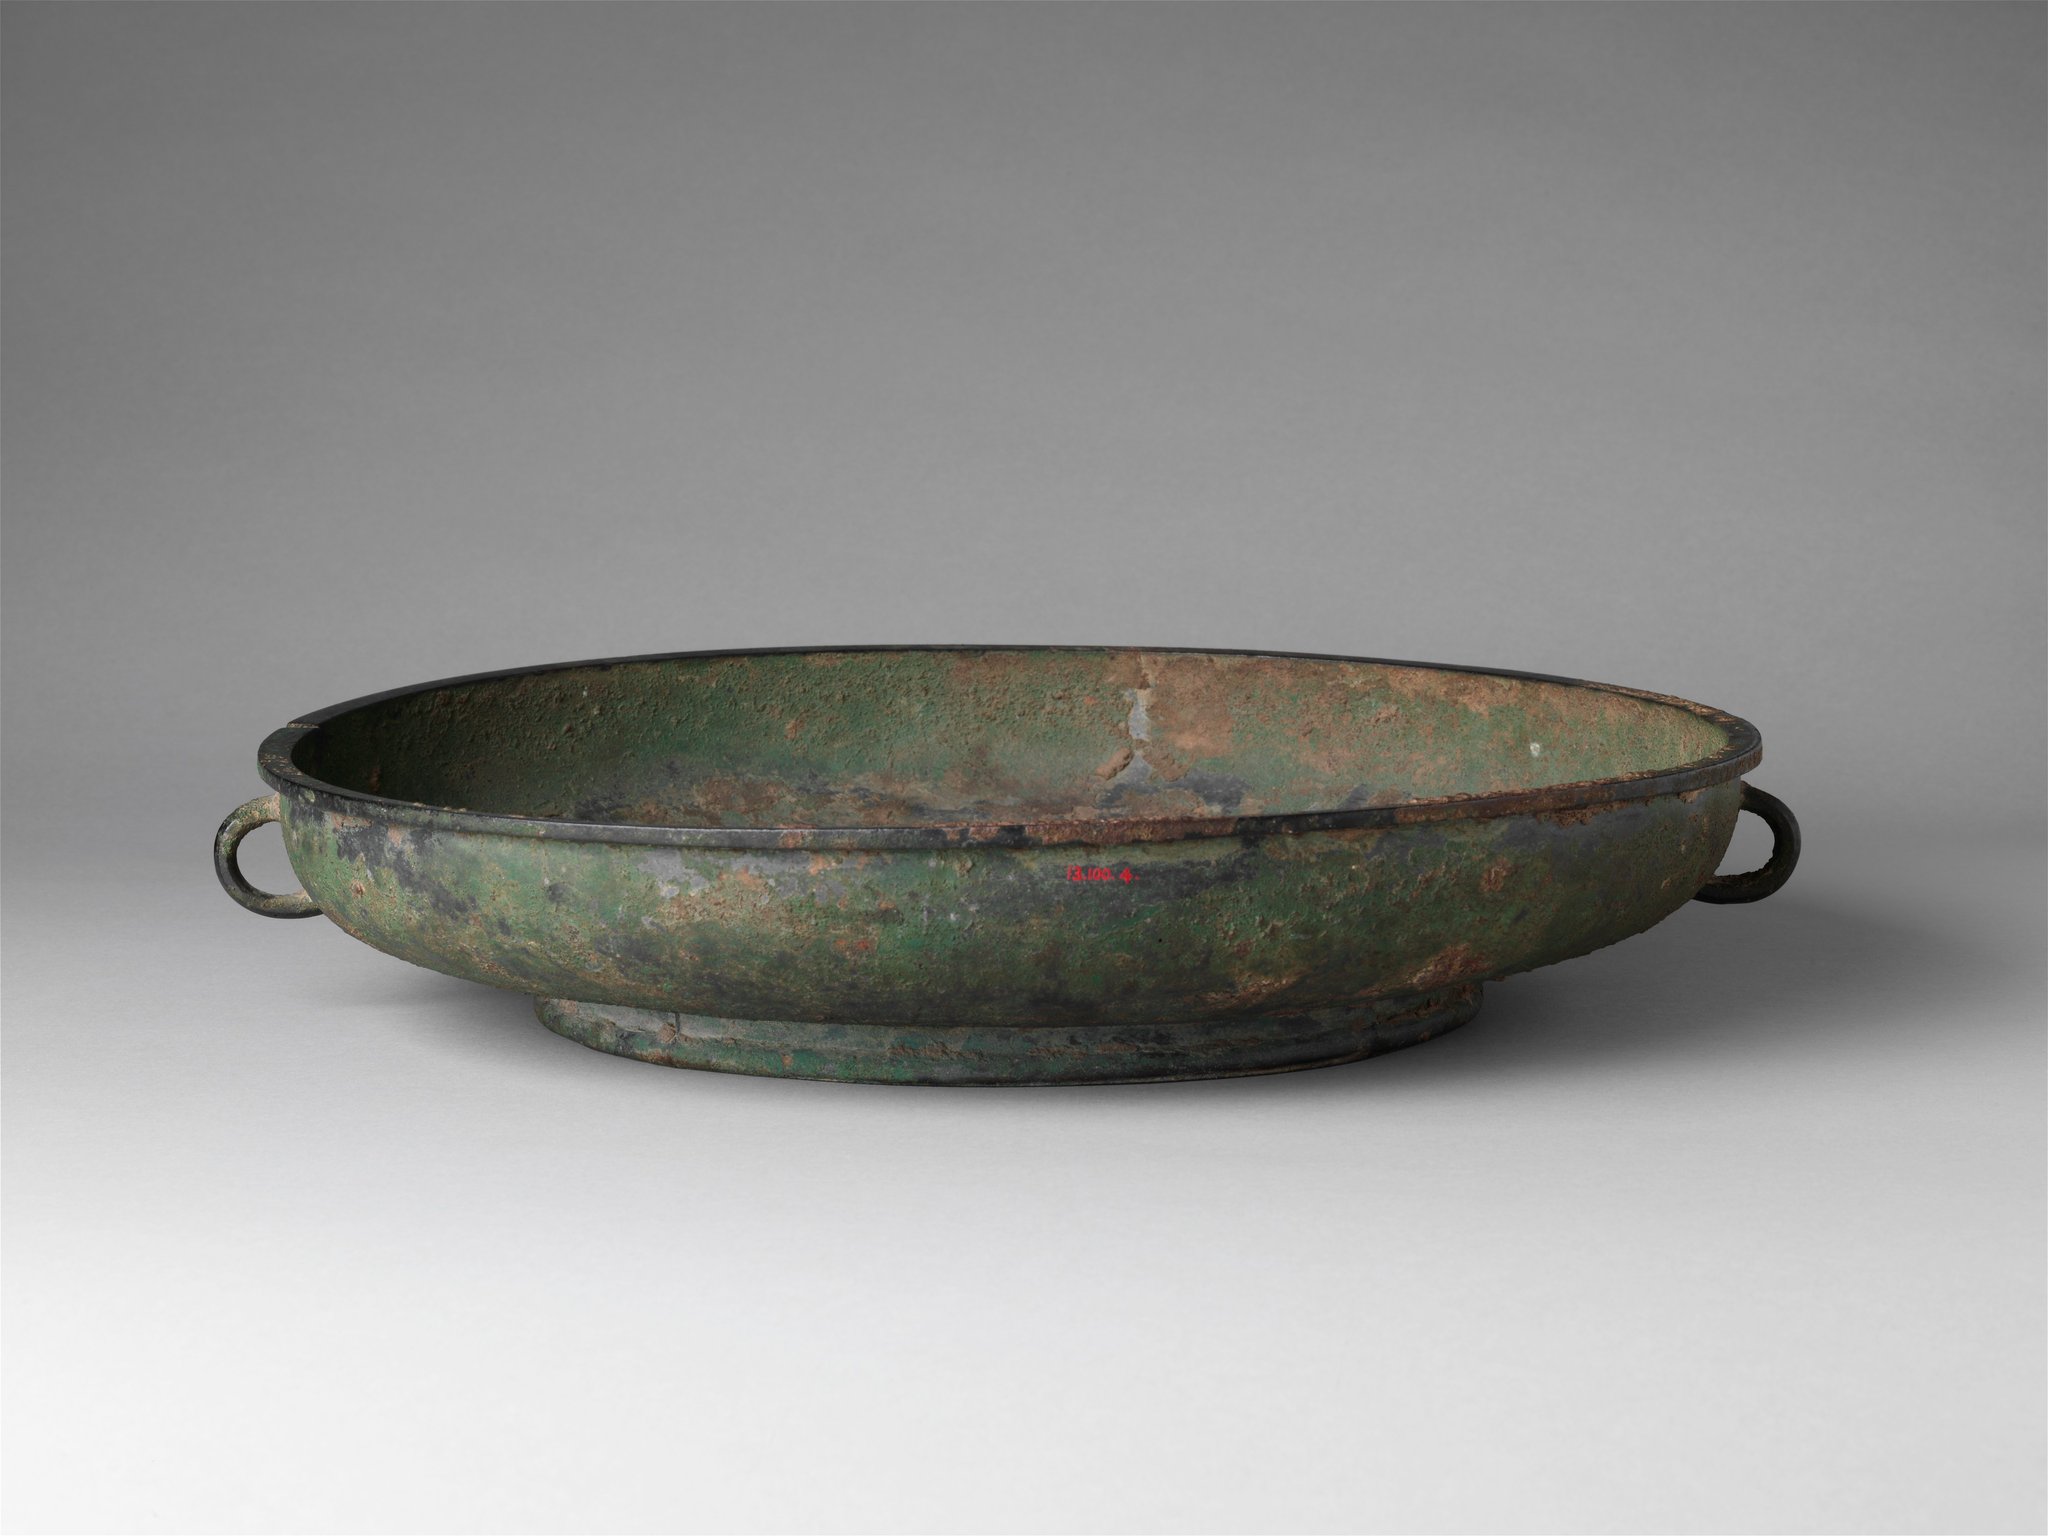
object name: basin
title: Basin (Pan)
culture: chinese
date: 600-501 BCE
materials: bronze